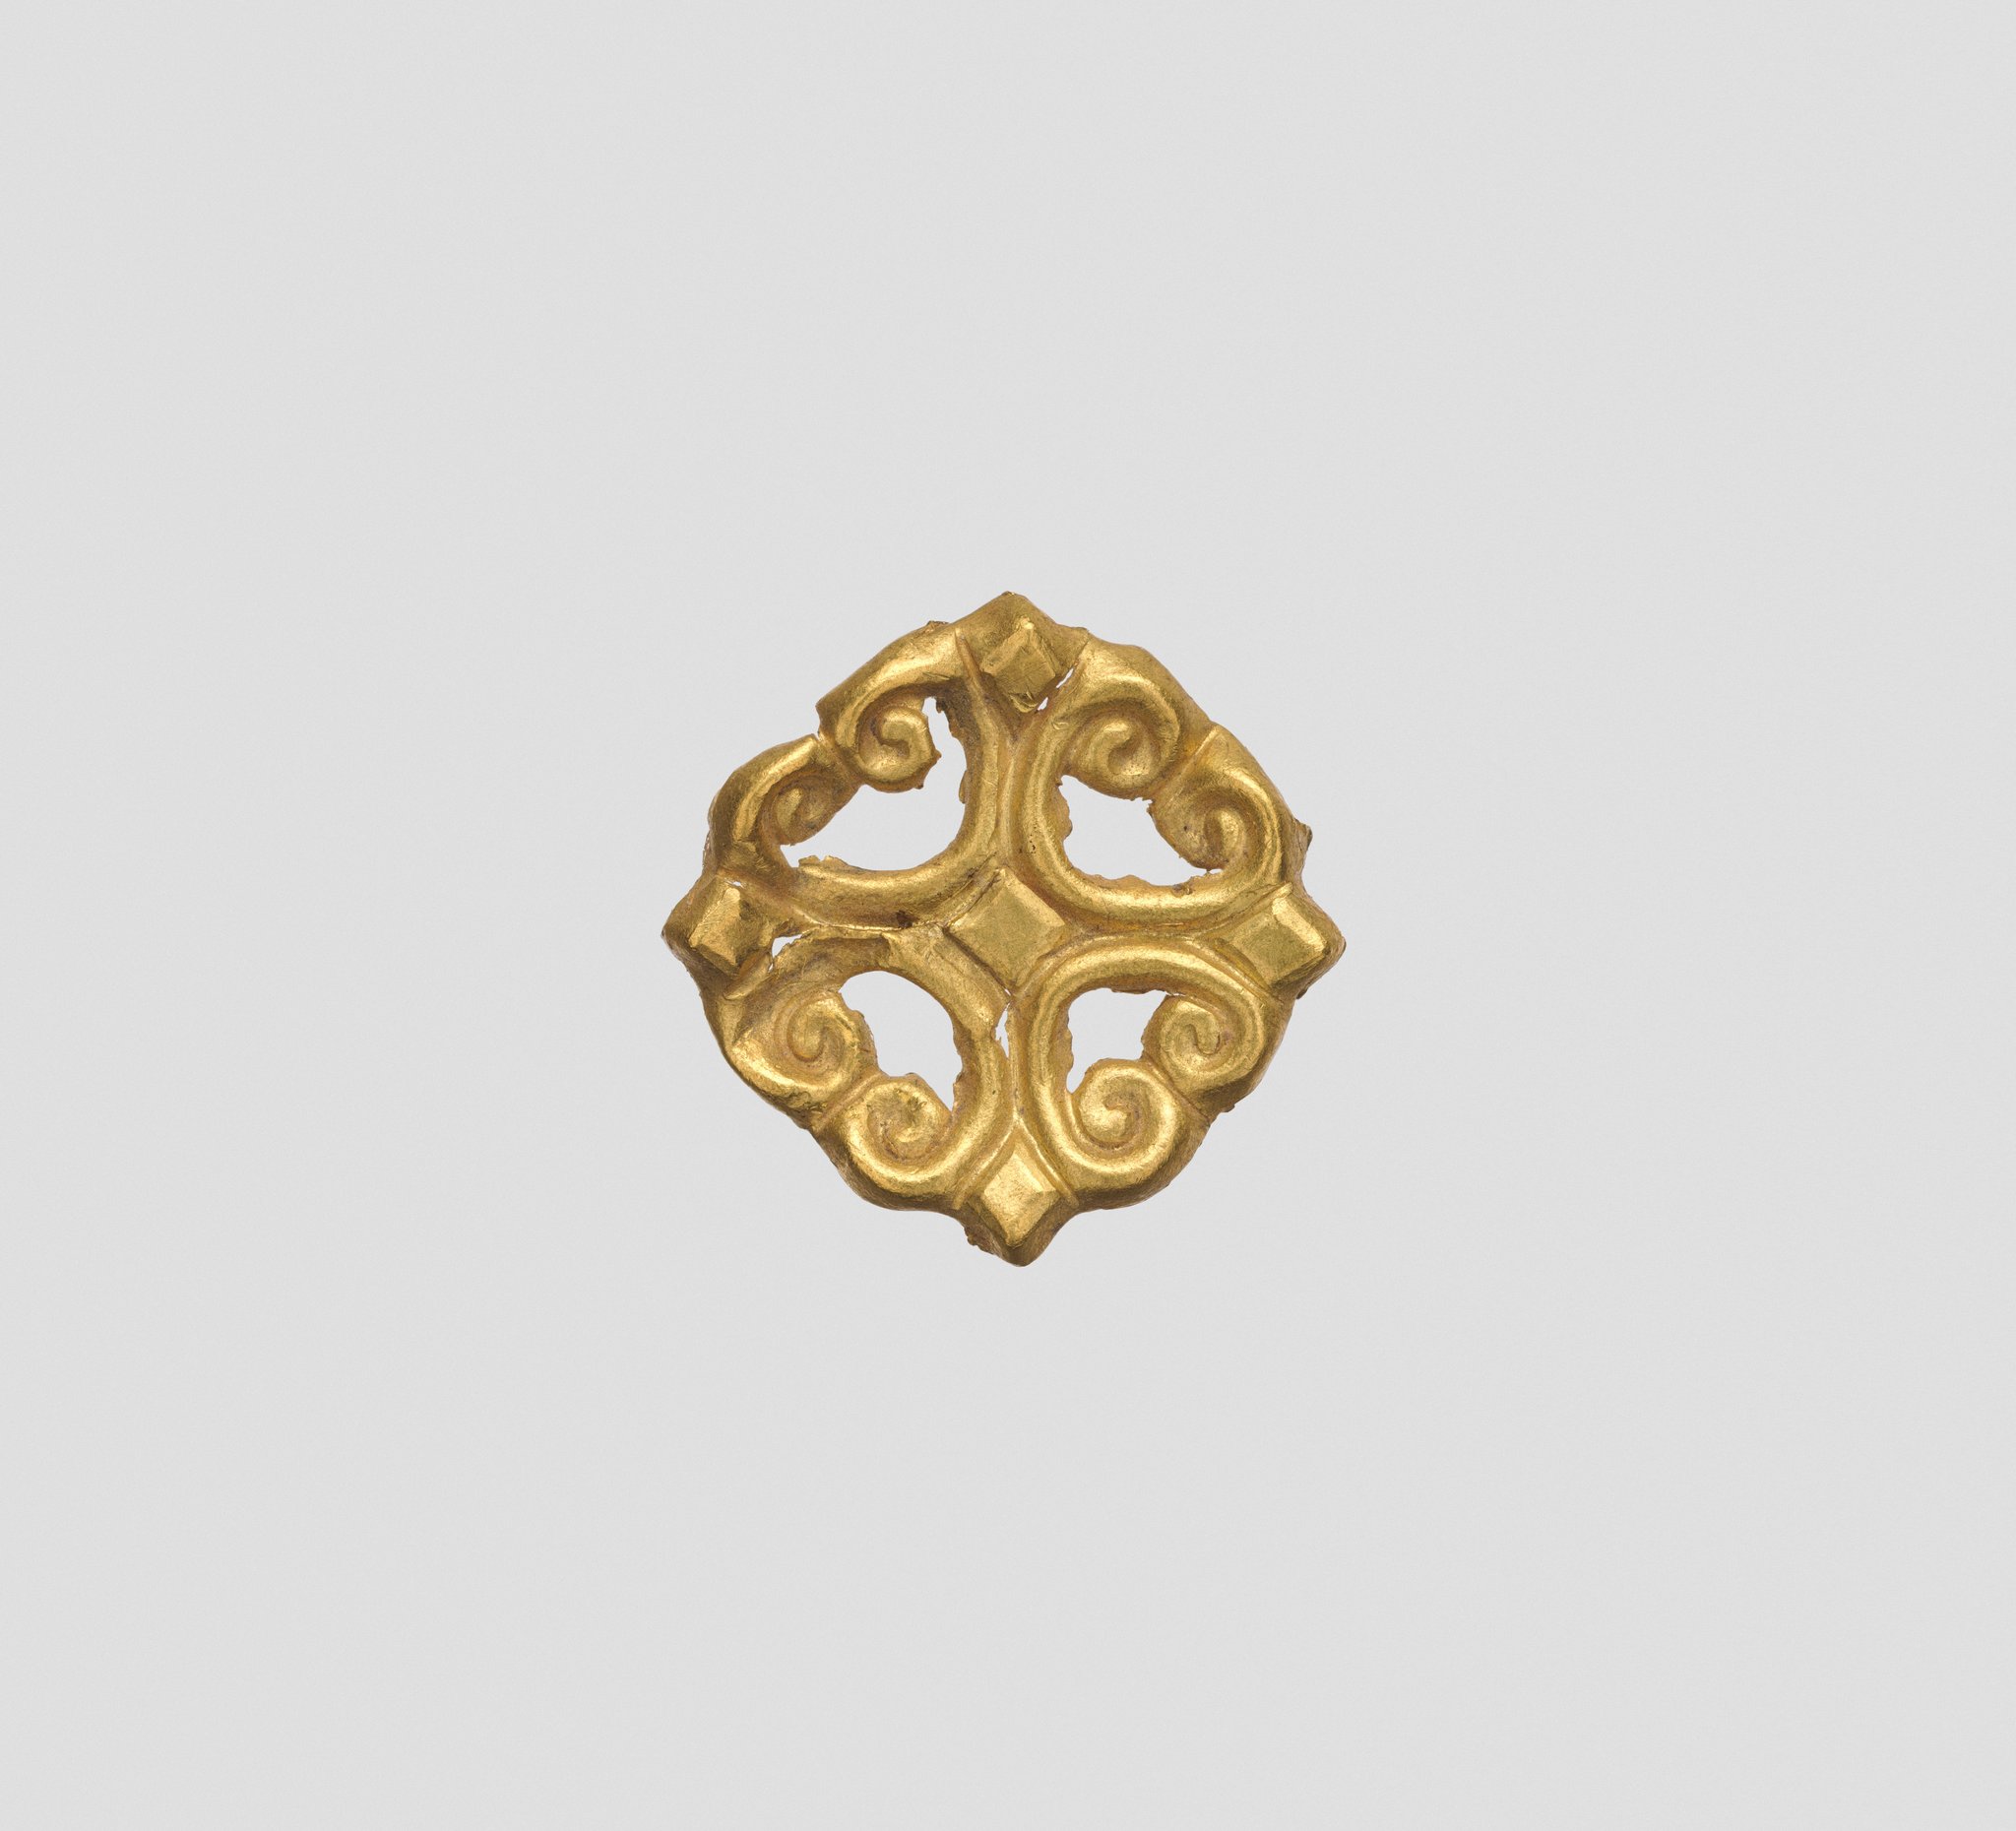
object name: dress ornament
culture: scythian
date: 500-401 BCE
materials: gold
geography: northern black sea region